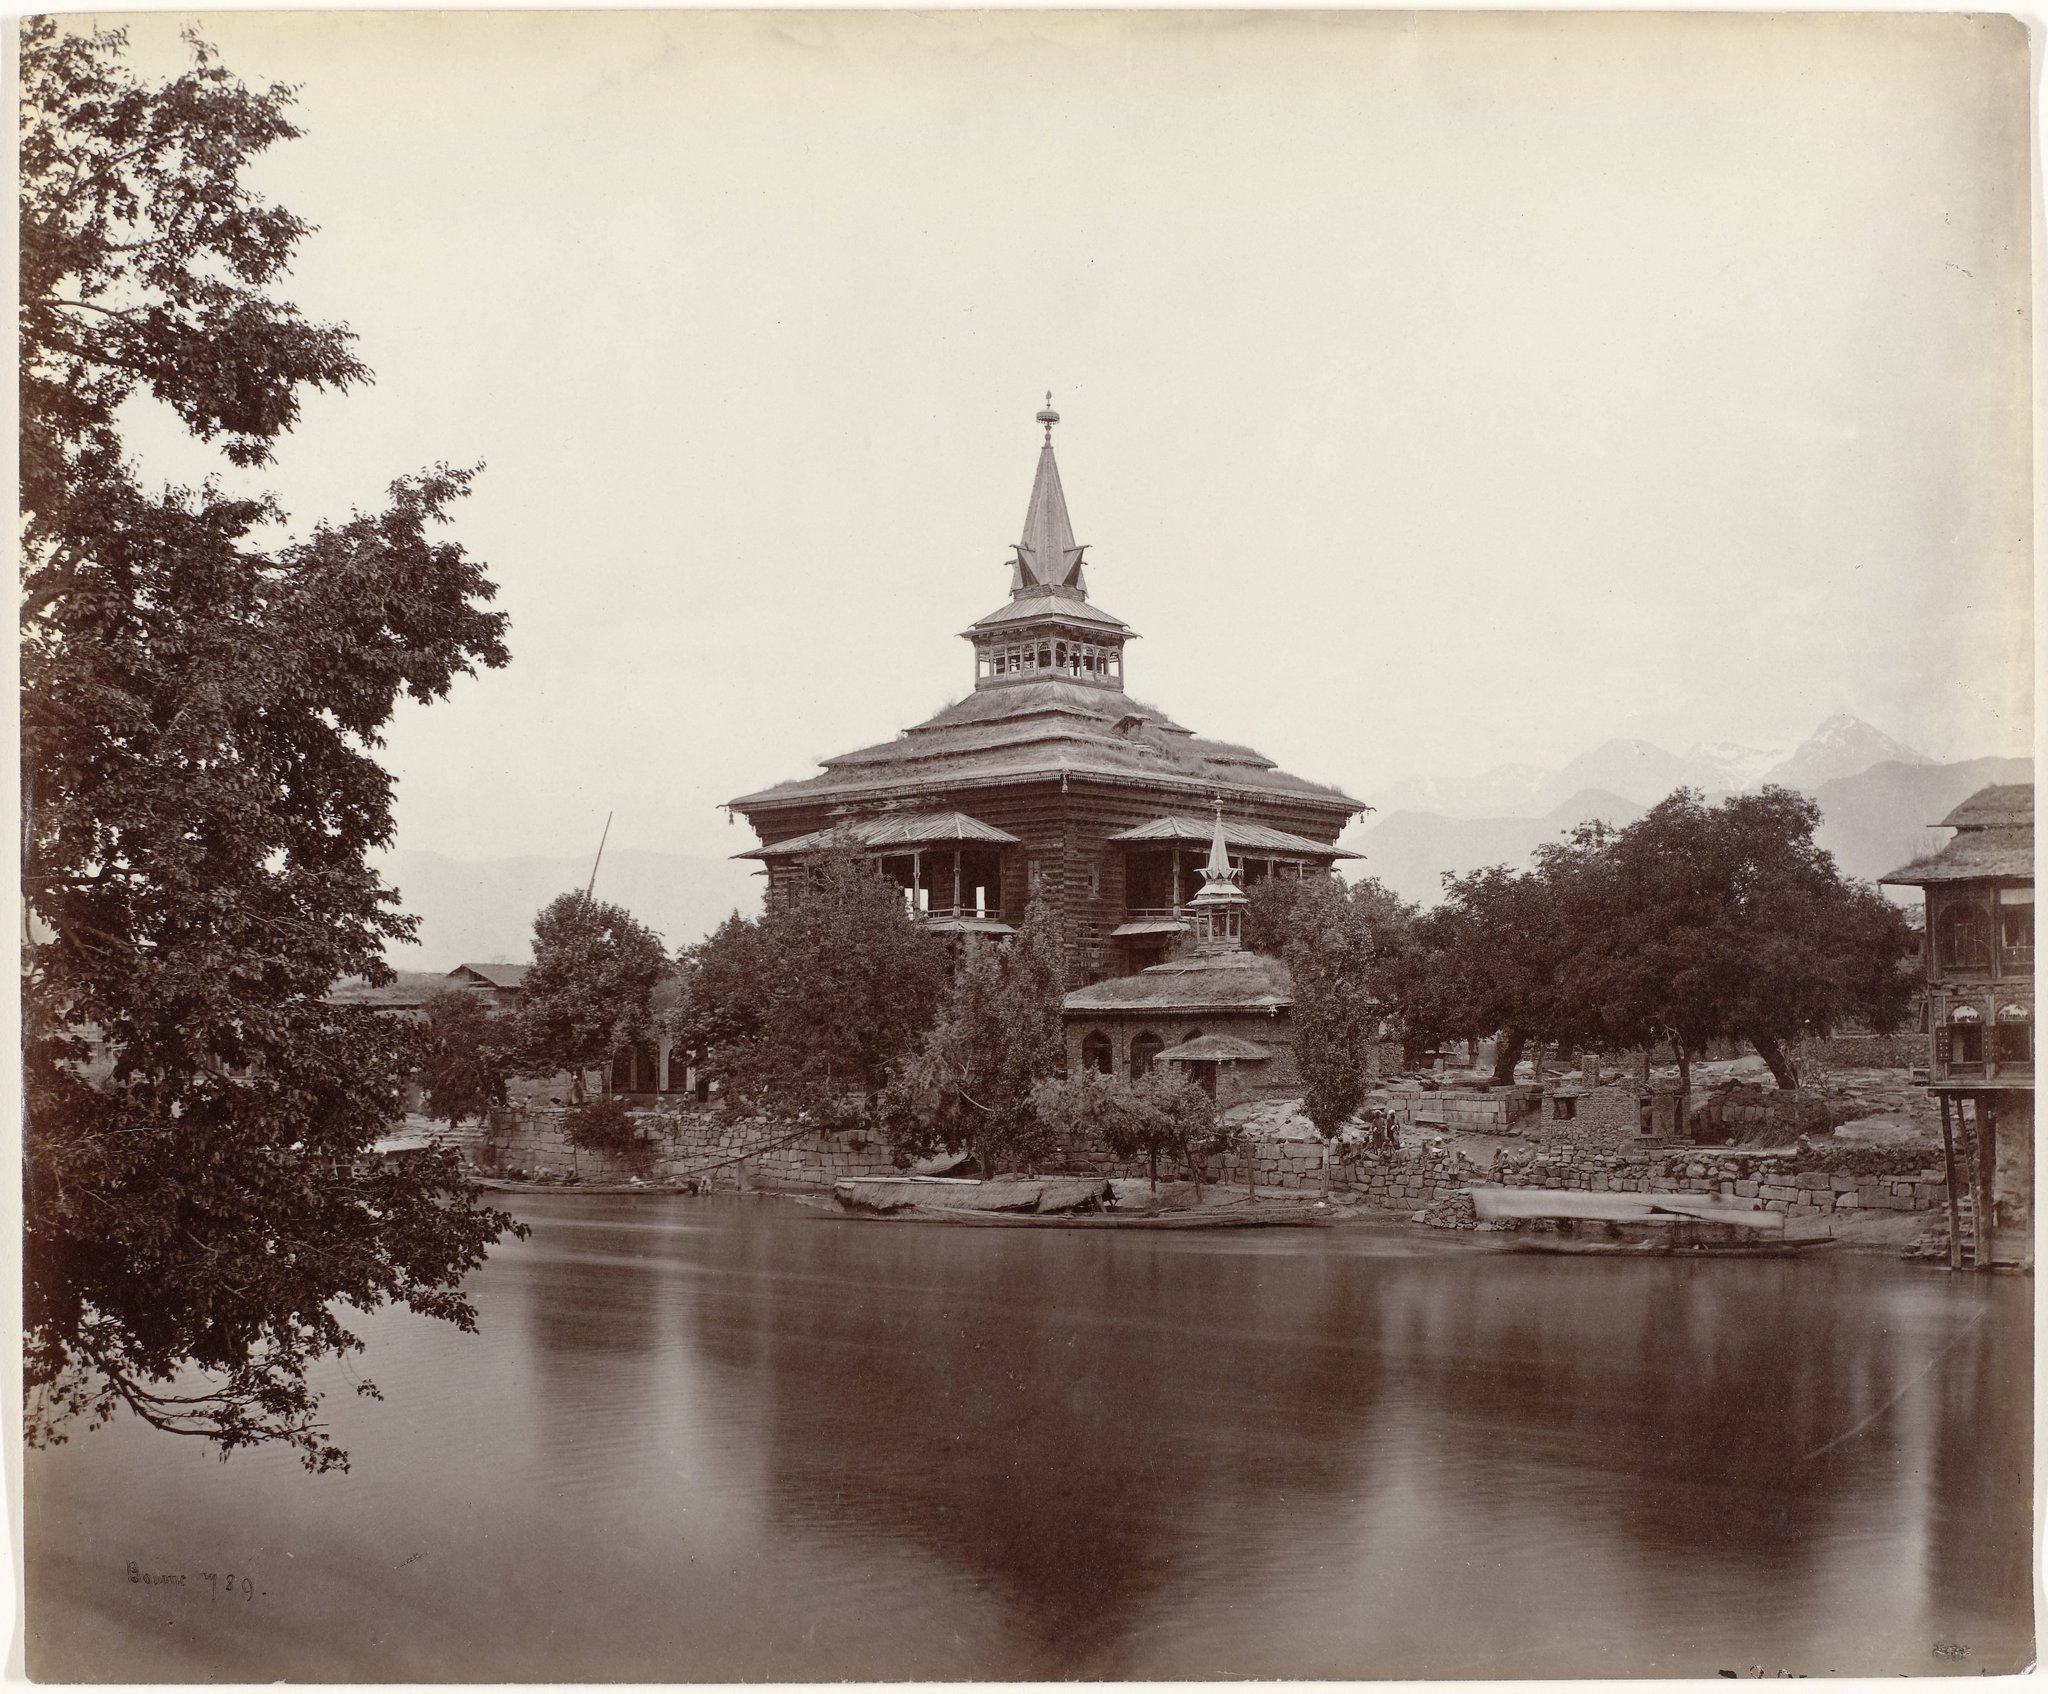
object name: photograph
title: View of the Shah-e-Hamdan mosque in Srinagar, Jammu & Kashmir, India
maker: samuel bourne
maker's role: fotograaf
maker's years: 1834-1912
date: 1864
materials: paper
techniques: albumen print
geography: srinagar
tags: temple, shrine ~ islam, mohammedanism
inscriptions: number: ‘789’, inscription: ‘789/ Kashmir/ Shah Hamadan Musjid, Srinuggur’, name: ‘Bourne’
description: Voorgrond Jhelum-rivier, achtergrond Himalaya-bergen